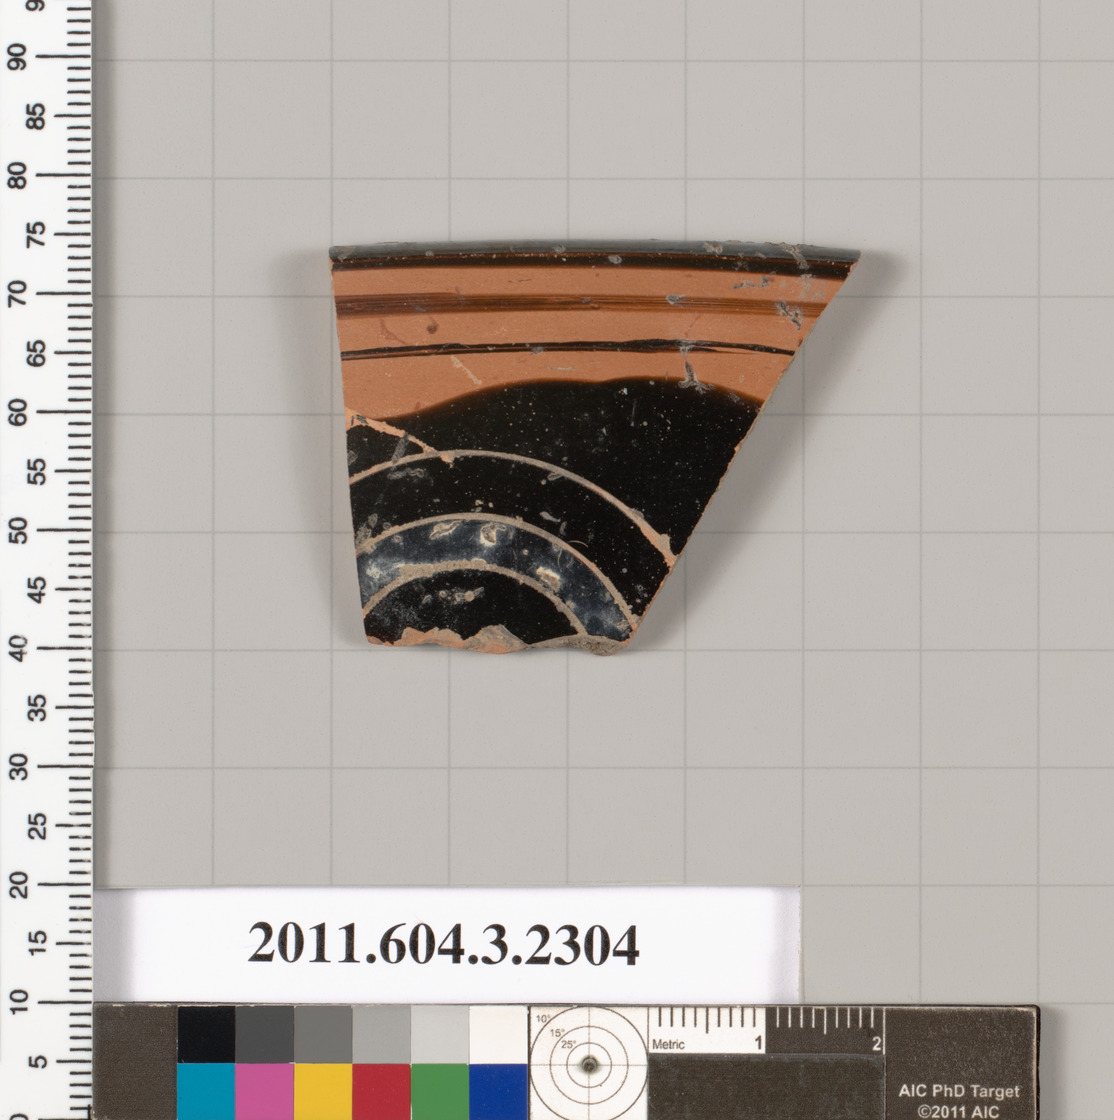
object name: kylix fragment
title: Terracotta rim fragment of a kylix: eye-cup (drinking cup)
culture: greek, attic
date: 530-510 BCE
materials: terracotta